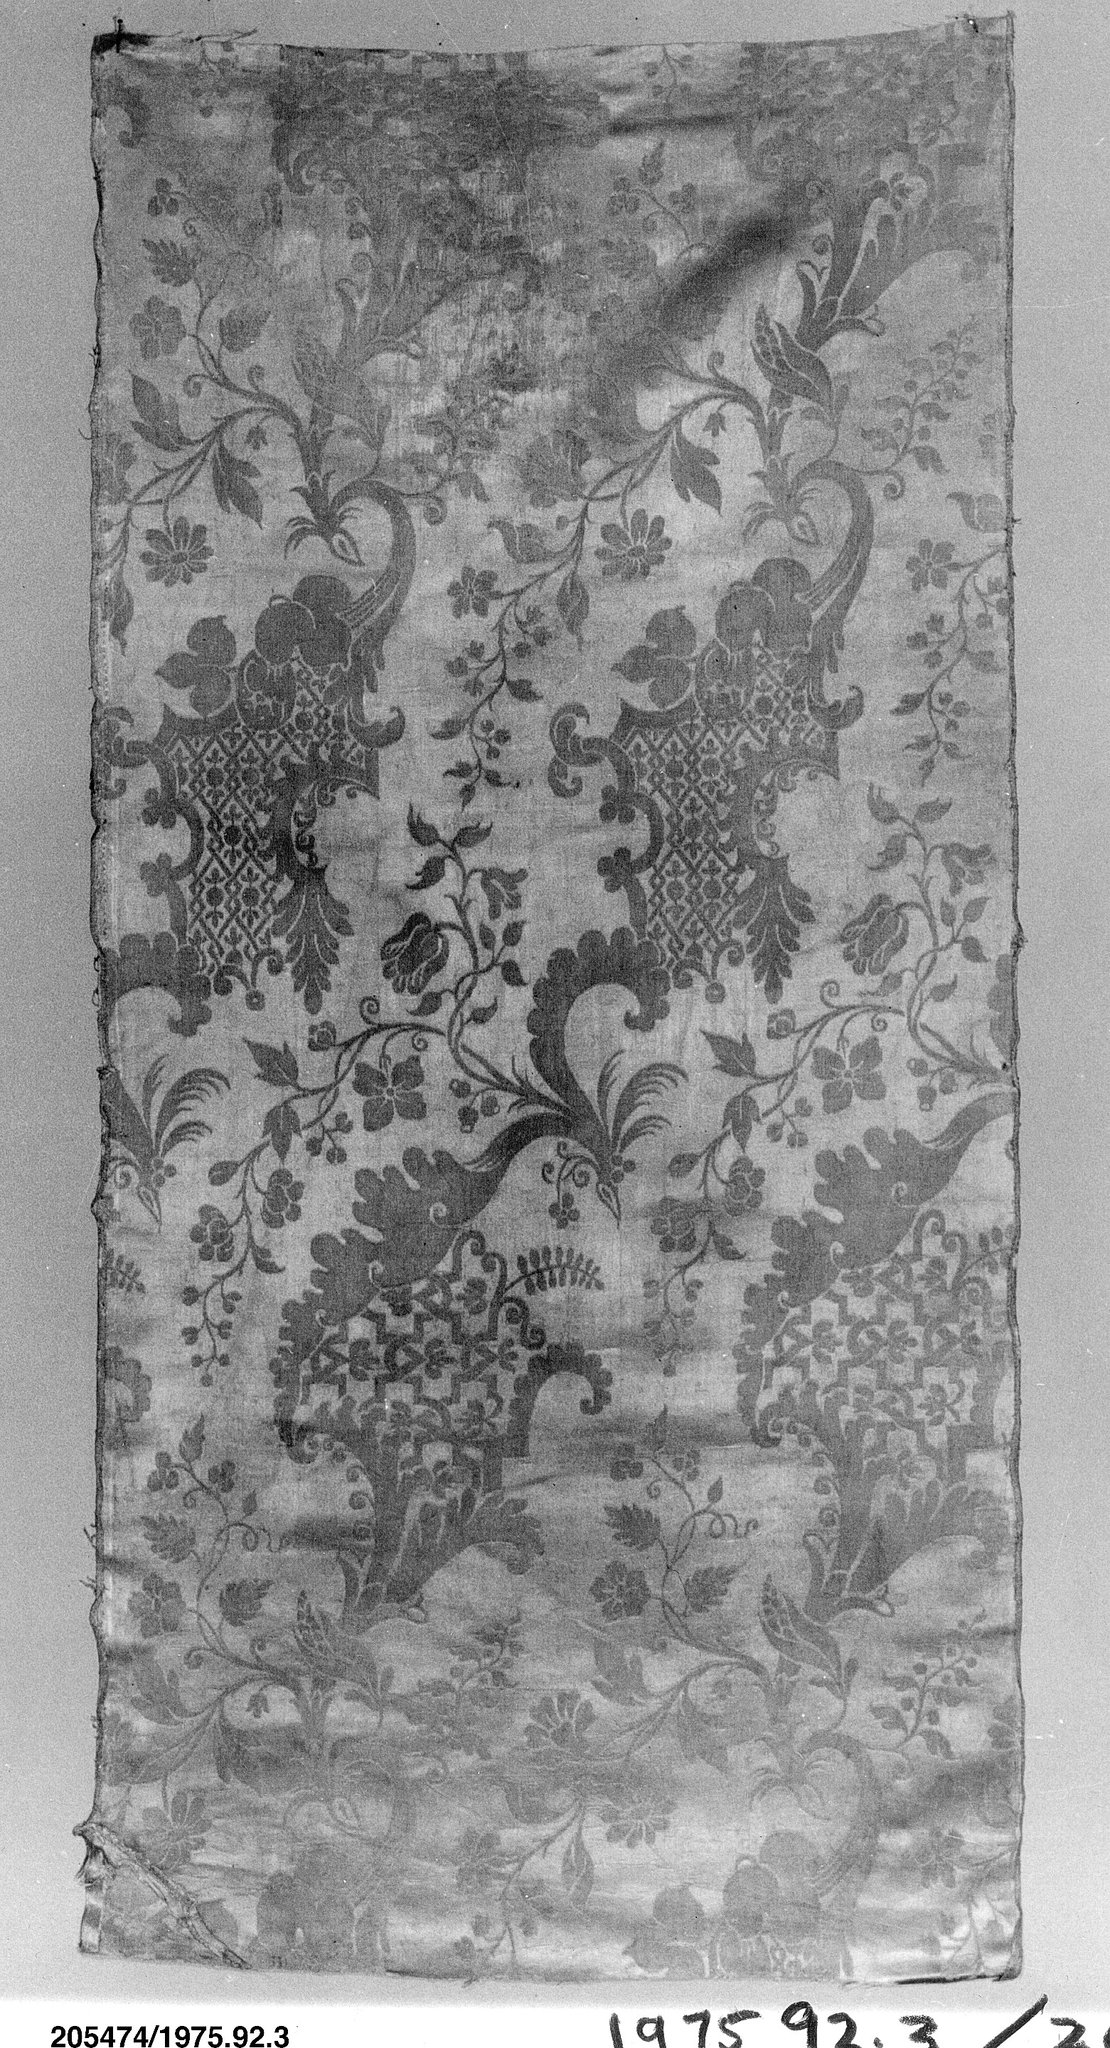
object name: length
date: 1700-1733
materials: silk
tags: flowers